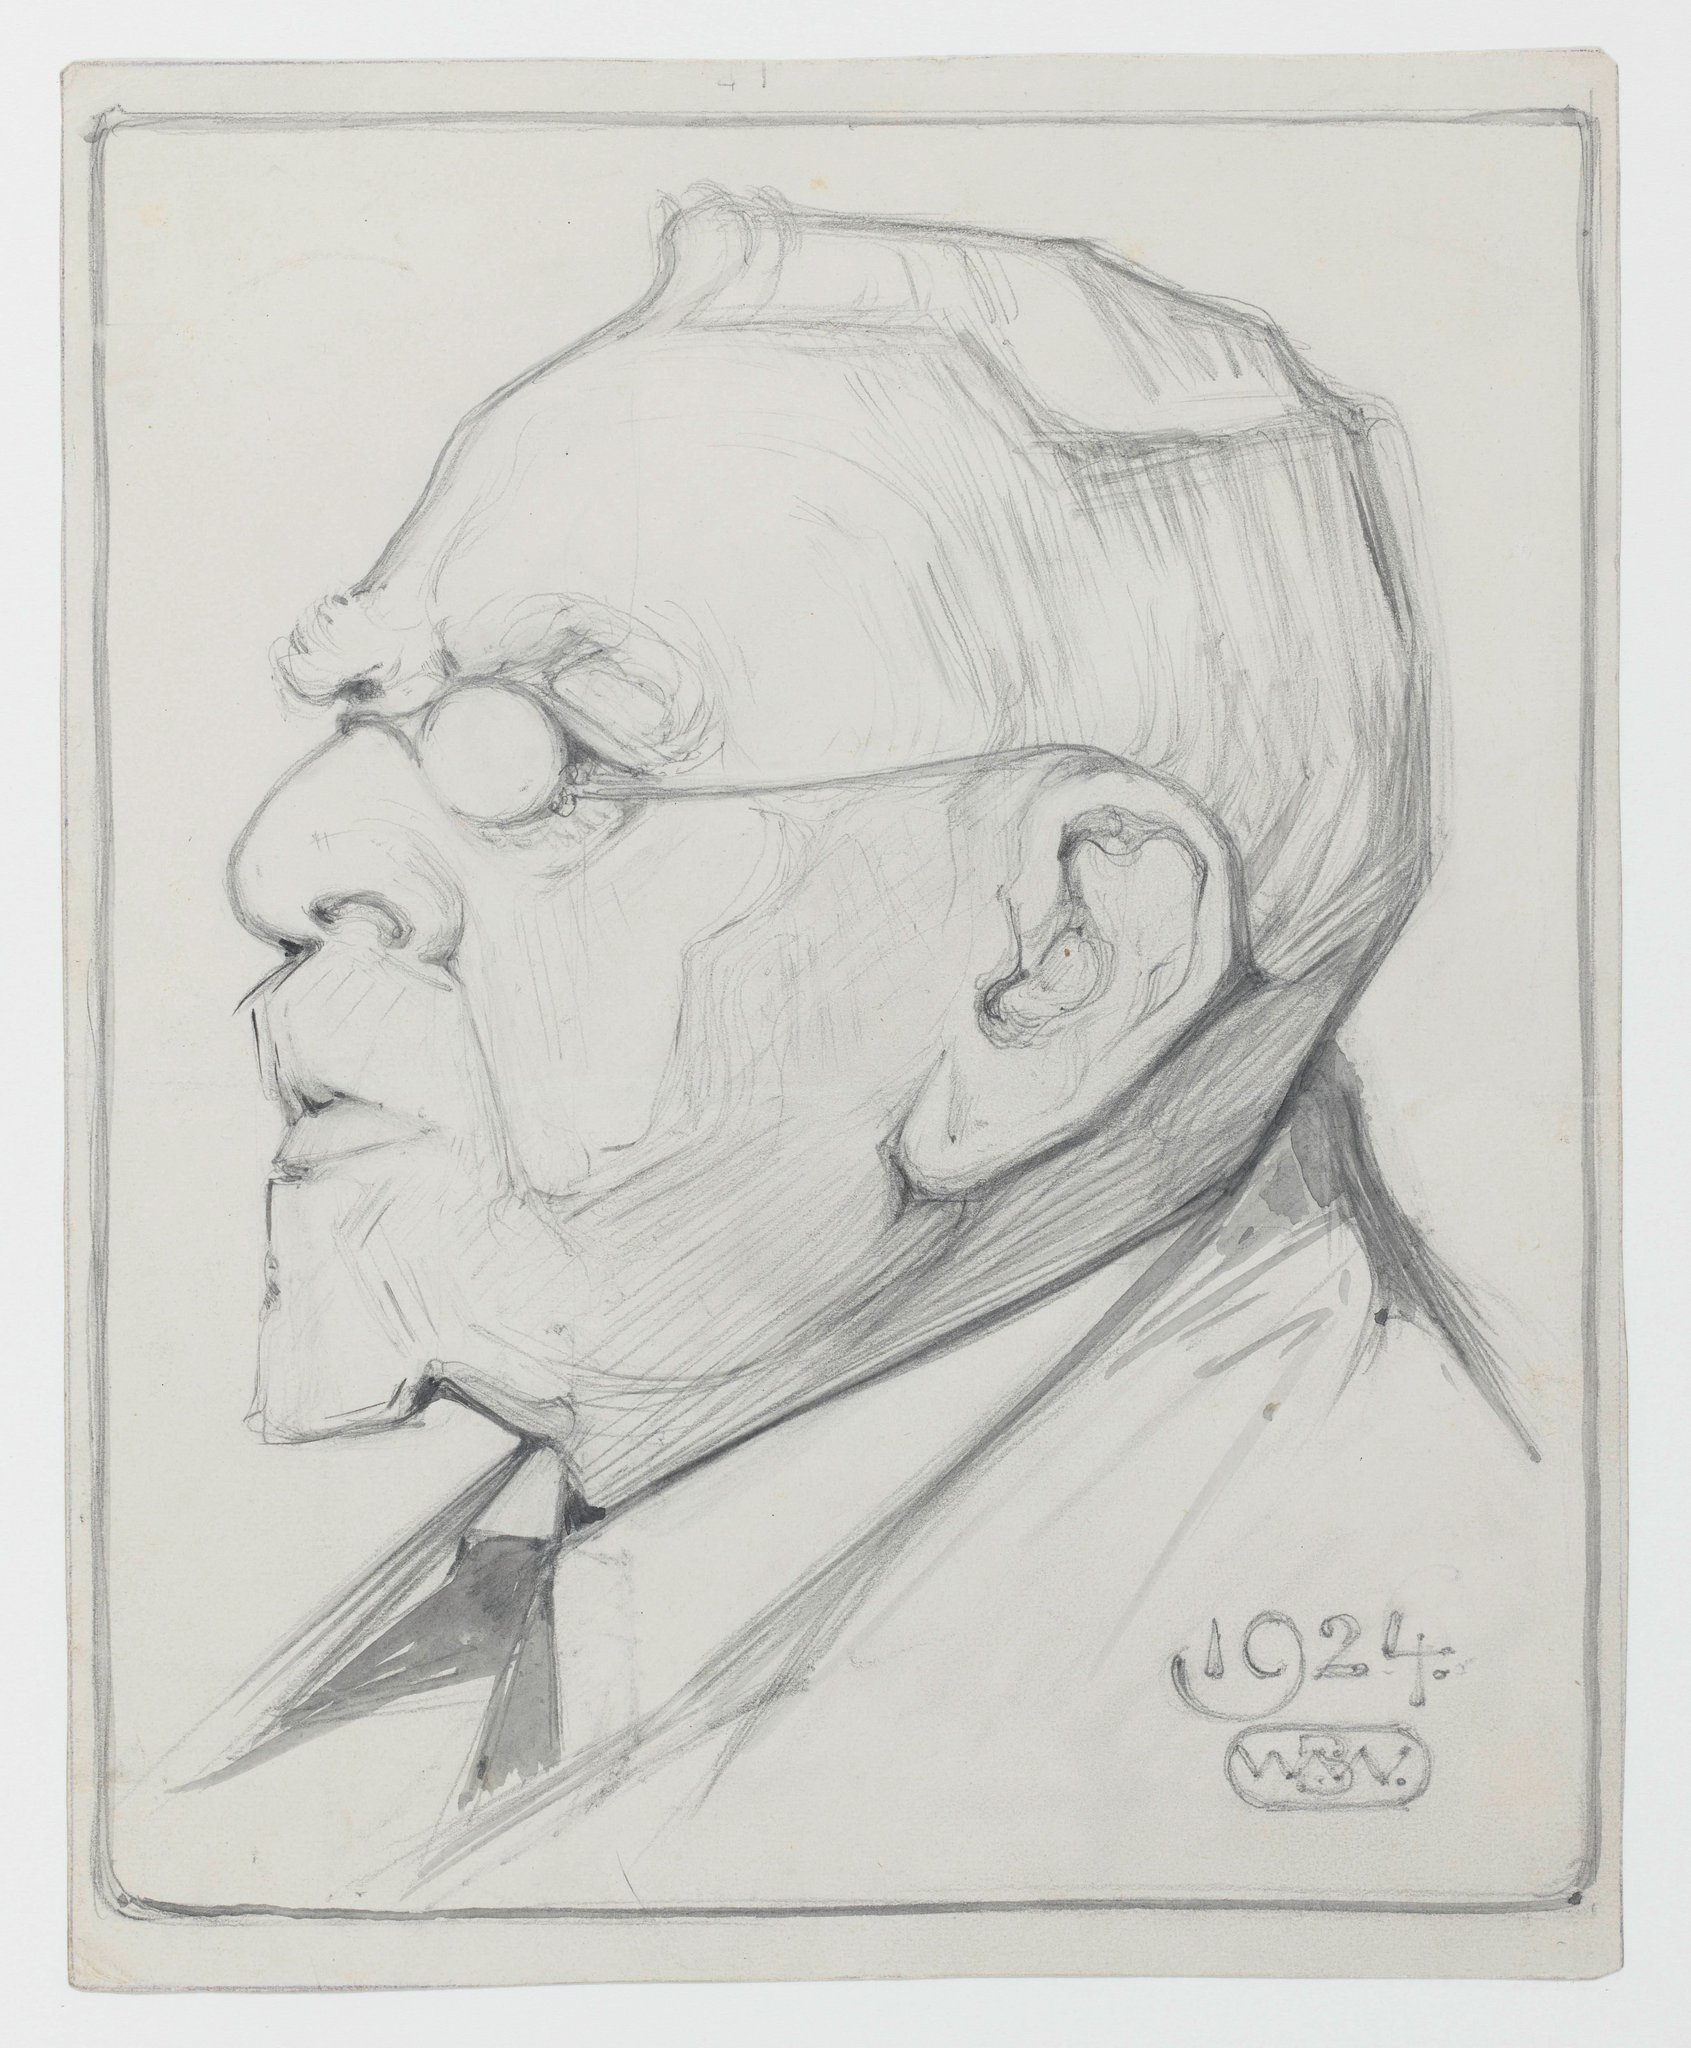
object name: drawing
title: Portret van August Allebé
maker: bernard willem wierink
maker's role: draughtsman, print maker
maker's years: 1856-1939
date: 1924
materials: paper, pencil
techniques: brush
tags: amsterdam, print maker, draughtsman, august allebé, historical persons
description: Portret van August Allebé; op verso een afdruk van Reintje de vos, die twee ganzen omhelst.